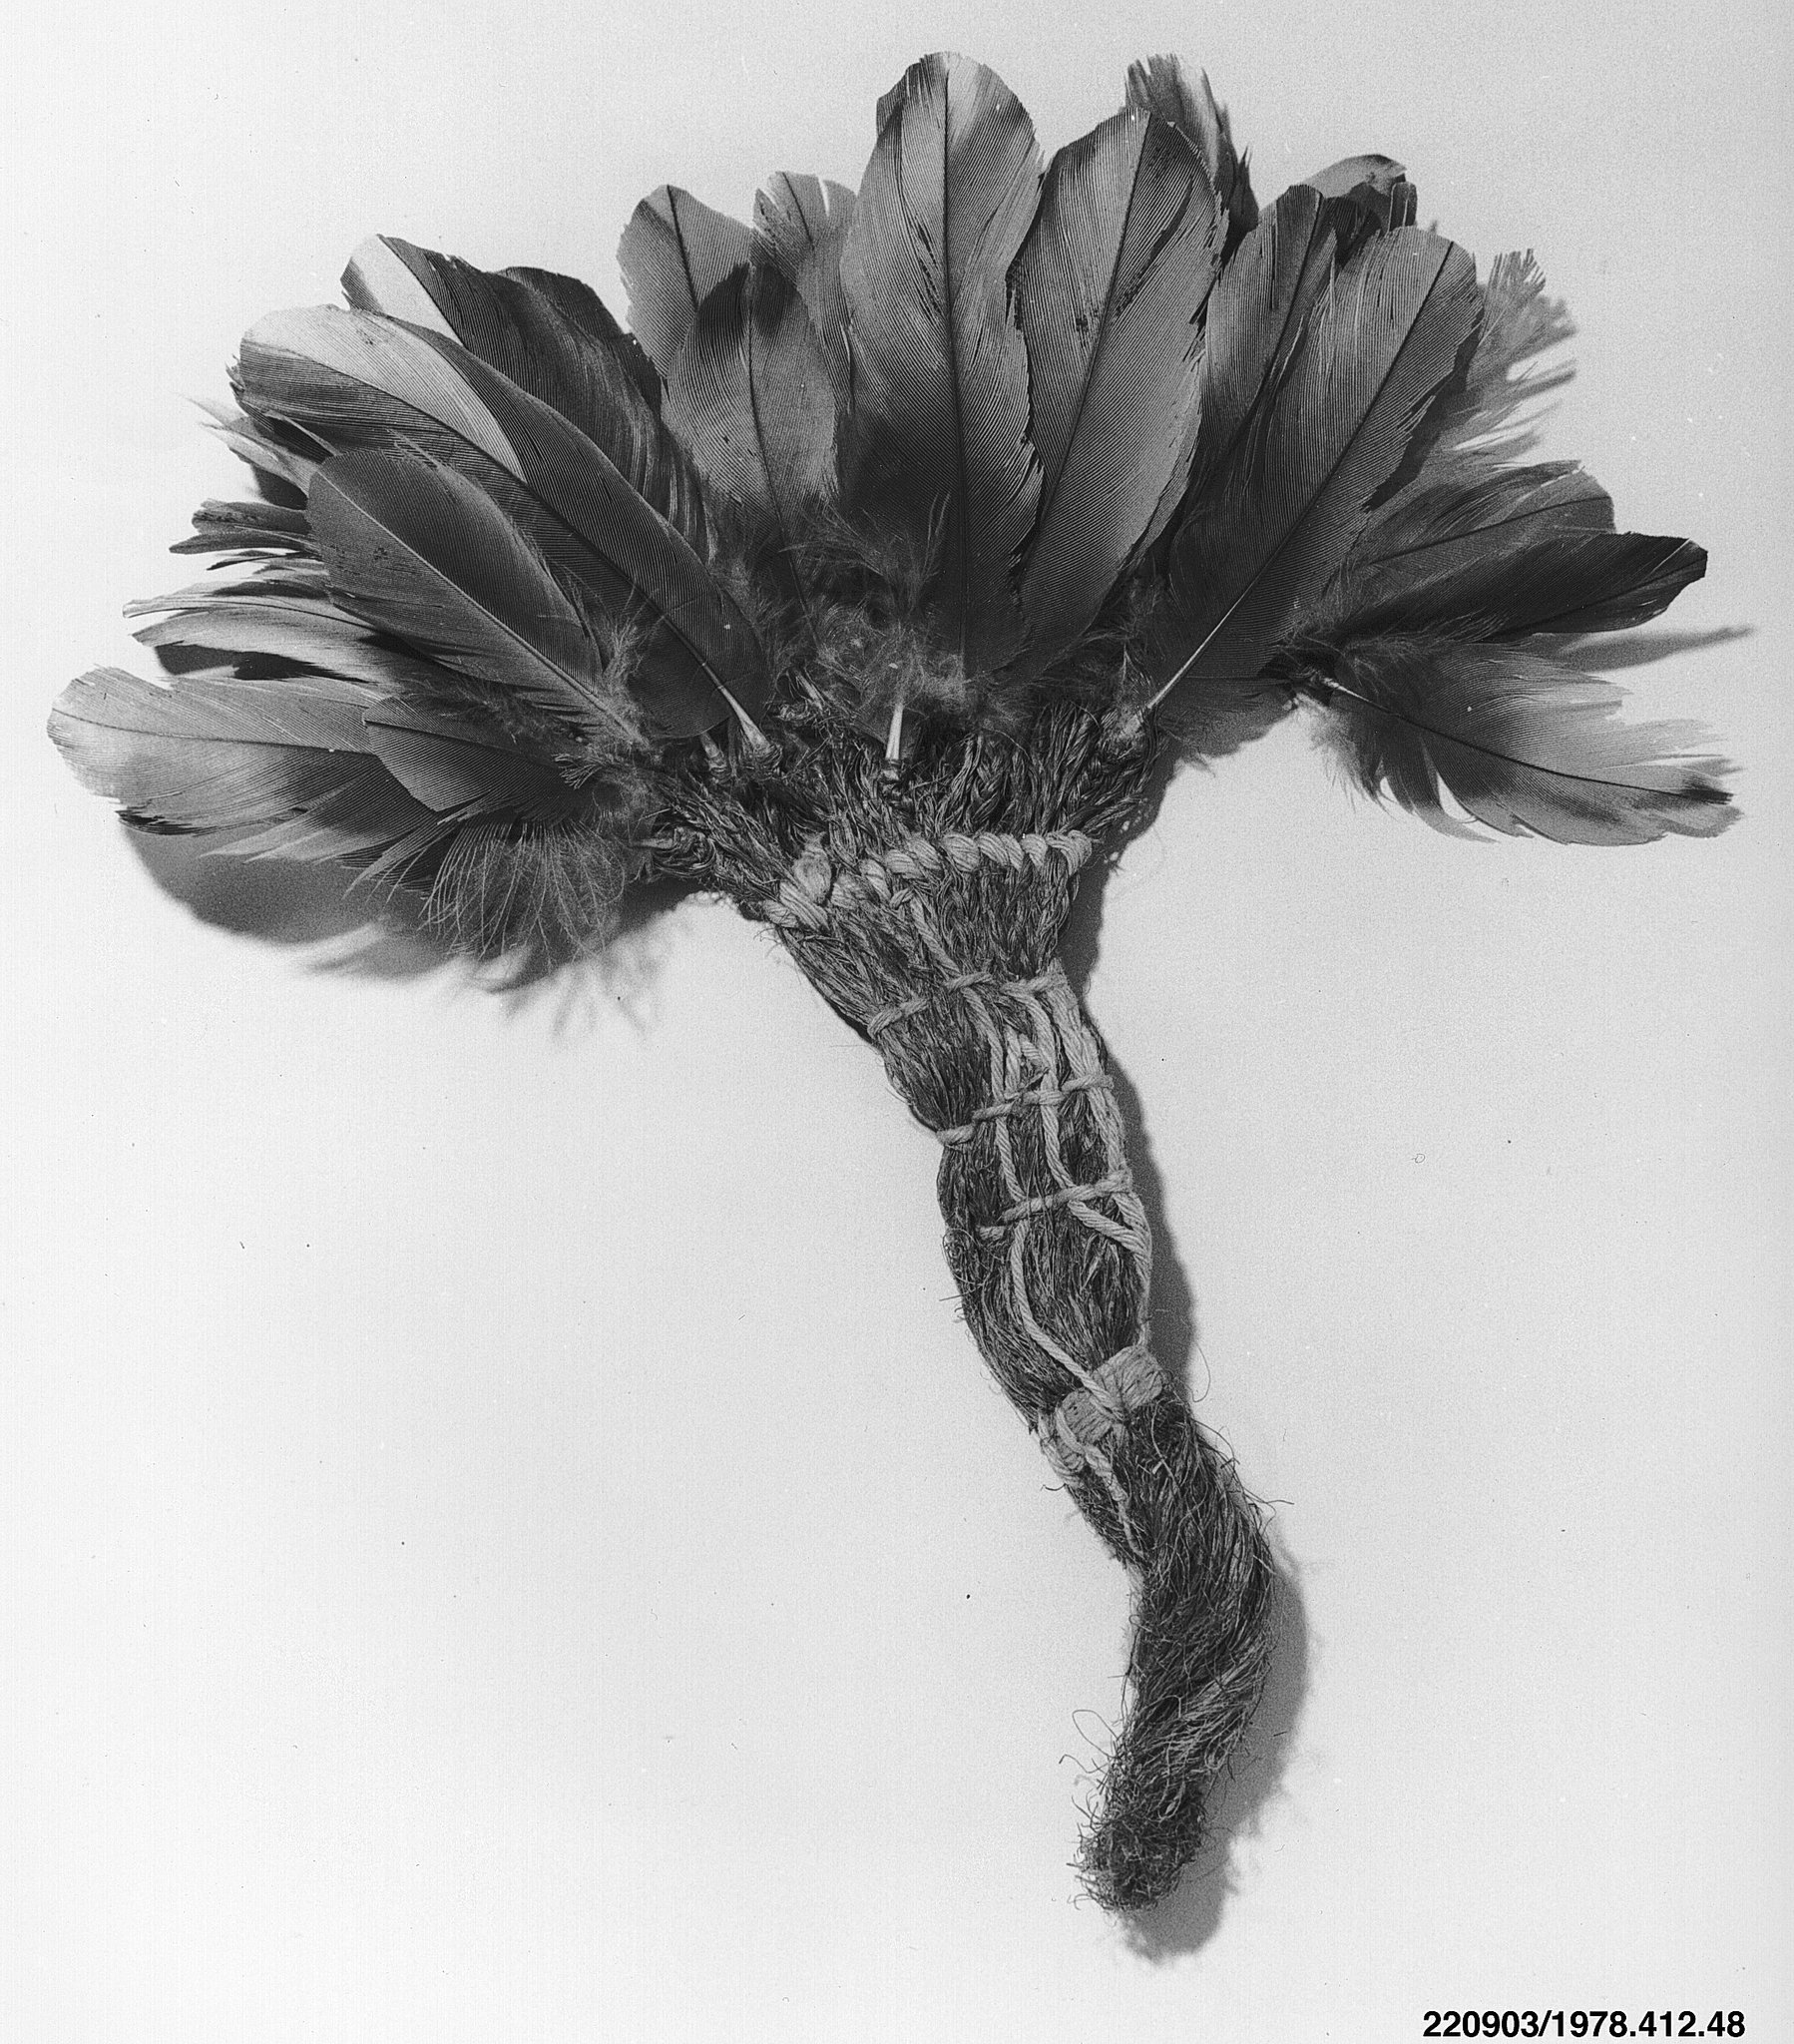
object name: ornament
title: Feathered Ornament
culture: central or south coast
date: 1001-1500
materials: cotton, feather, fiber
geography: peru